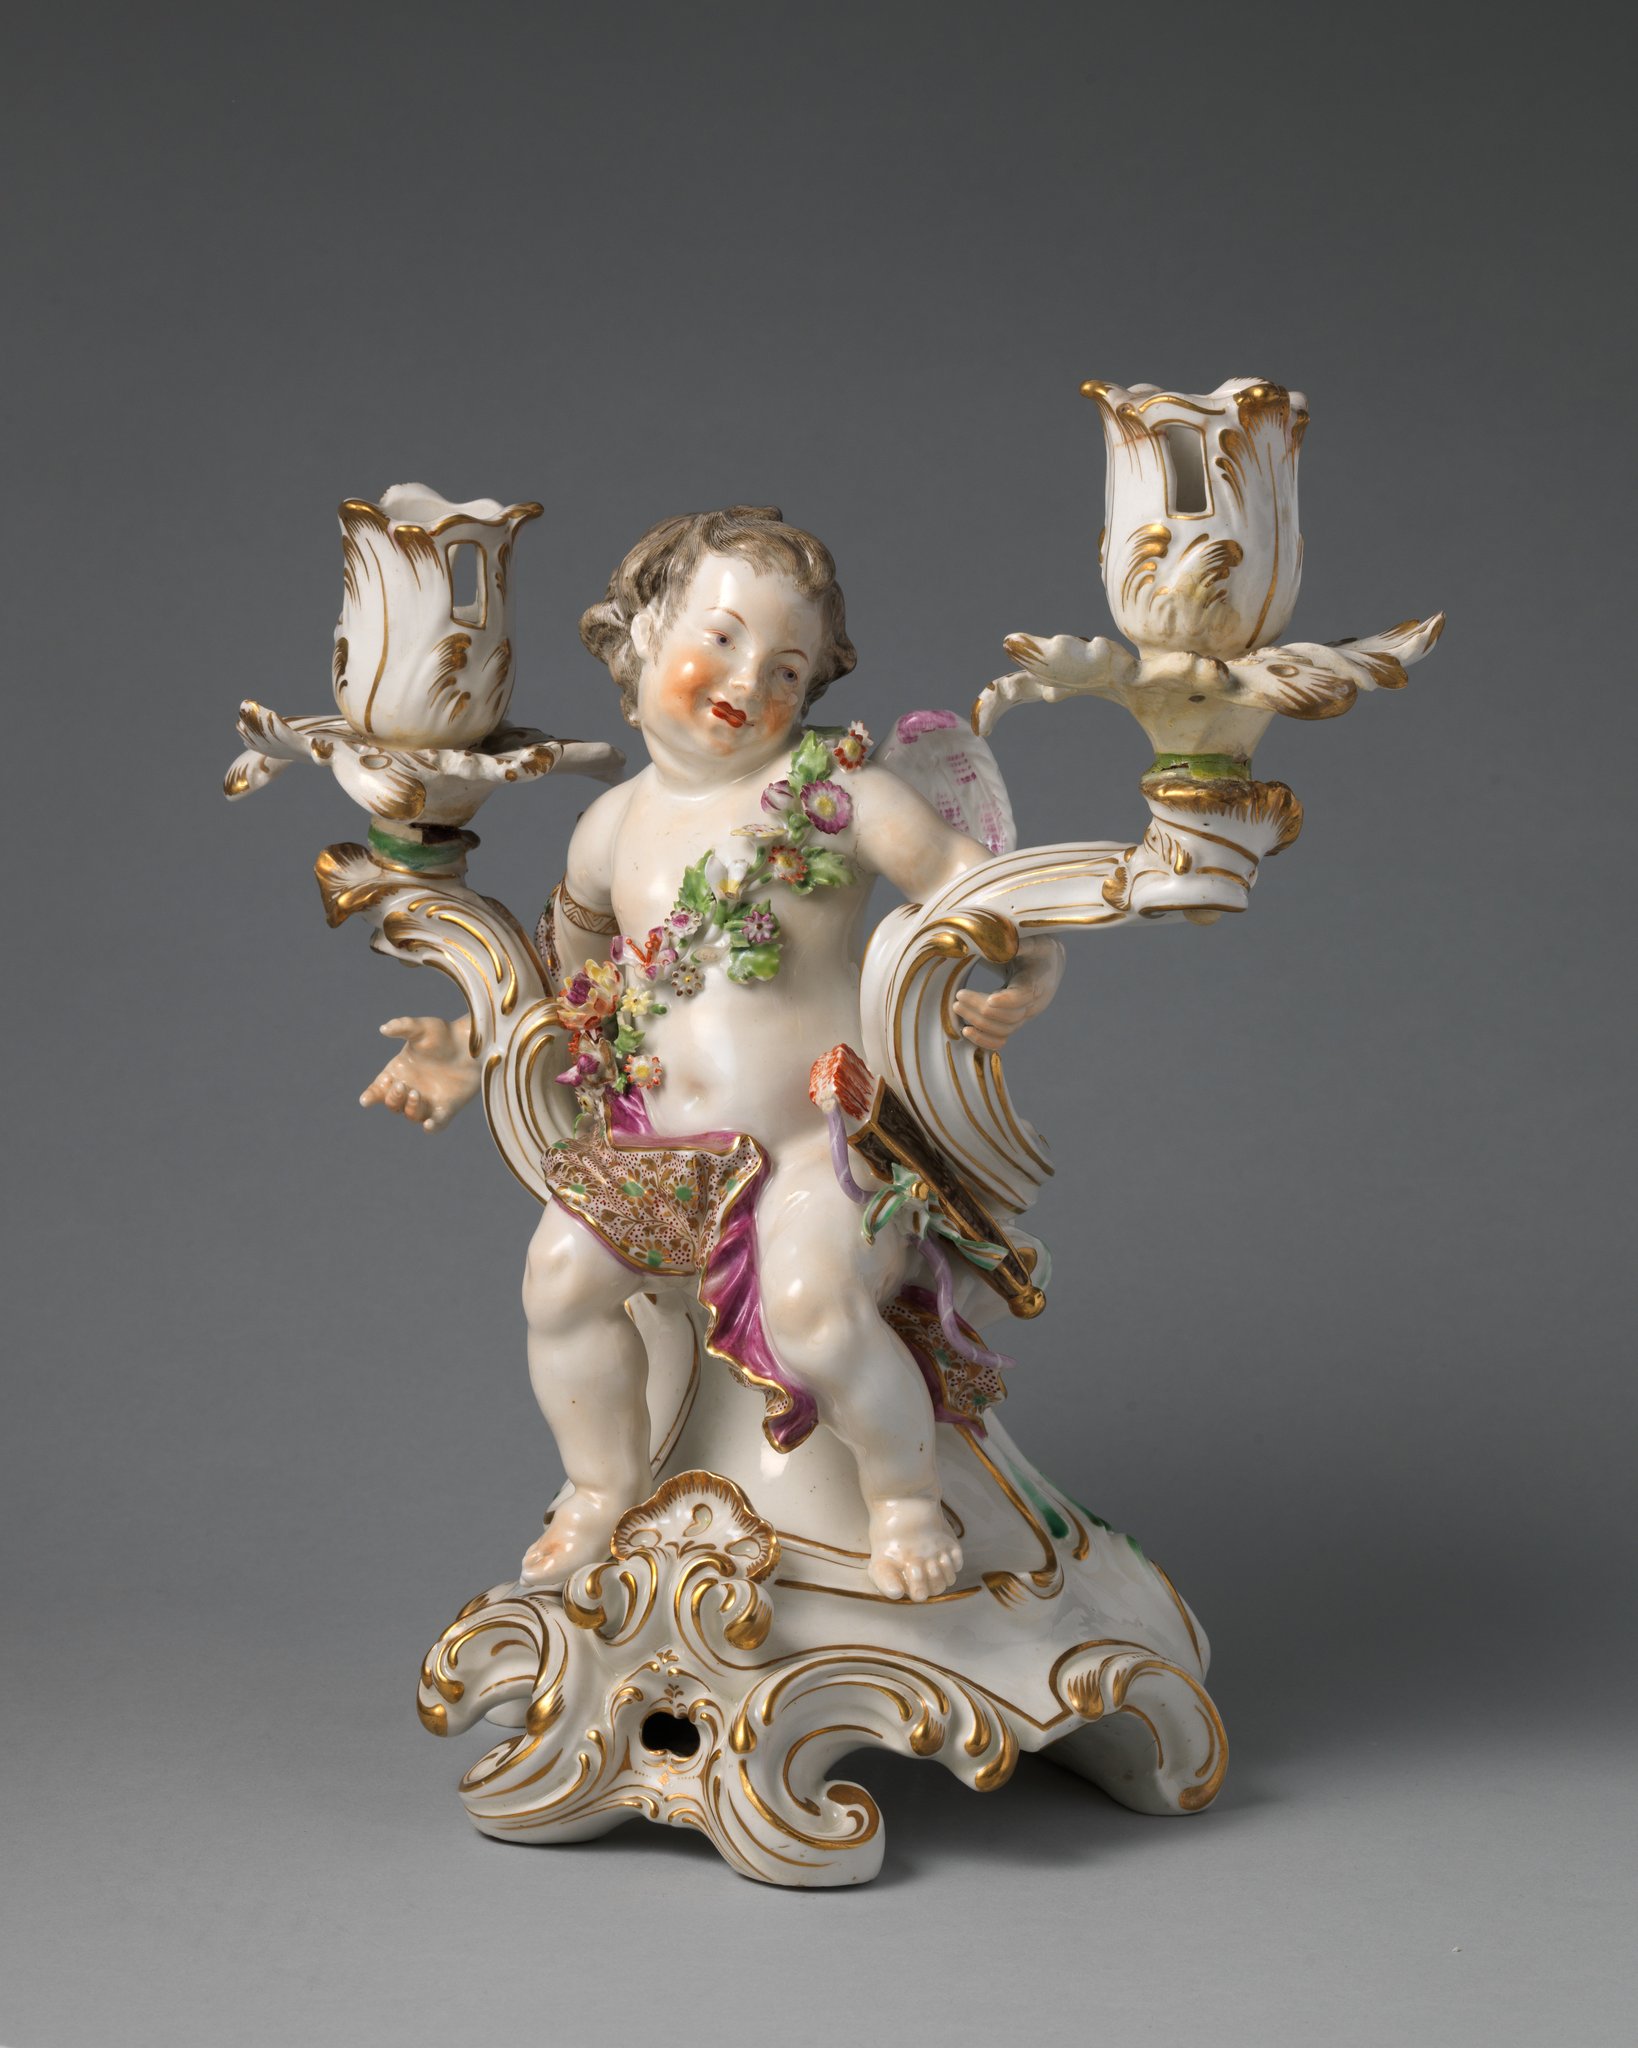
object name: candelabrum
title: Candelabrum (one of a pair)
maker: chelsea porcelain manufactory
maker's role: factory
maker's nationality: british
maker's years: 1744-1784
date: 1701-1800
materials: soft paste porcelain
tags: cupid